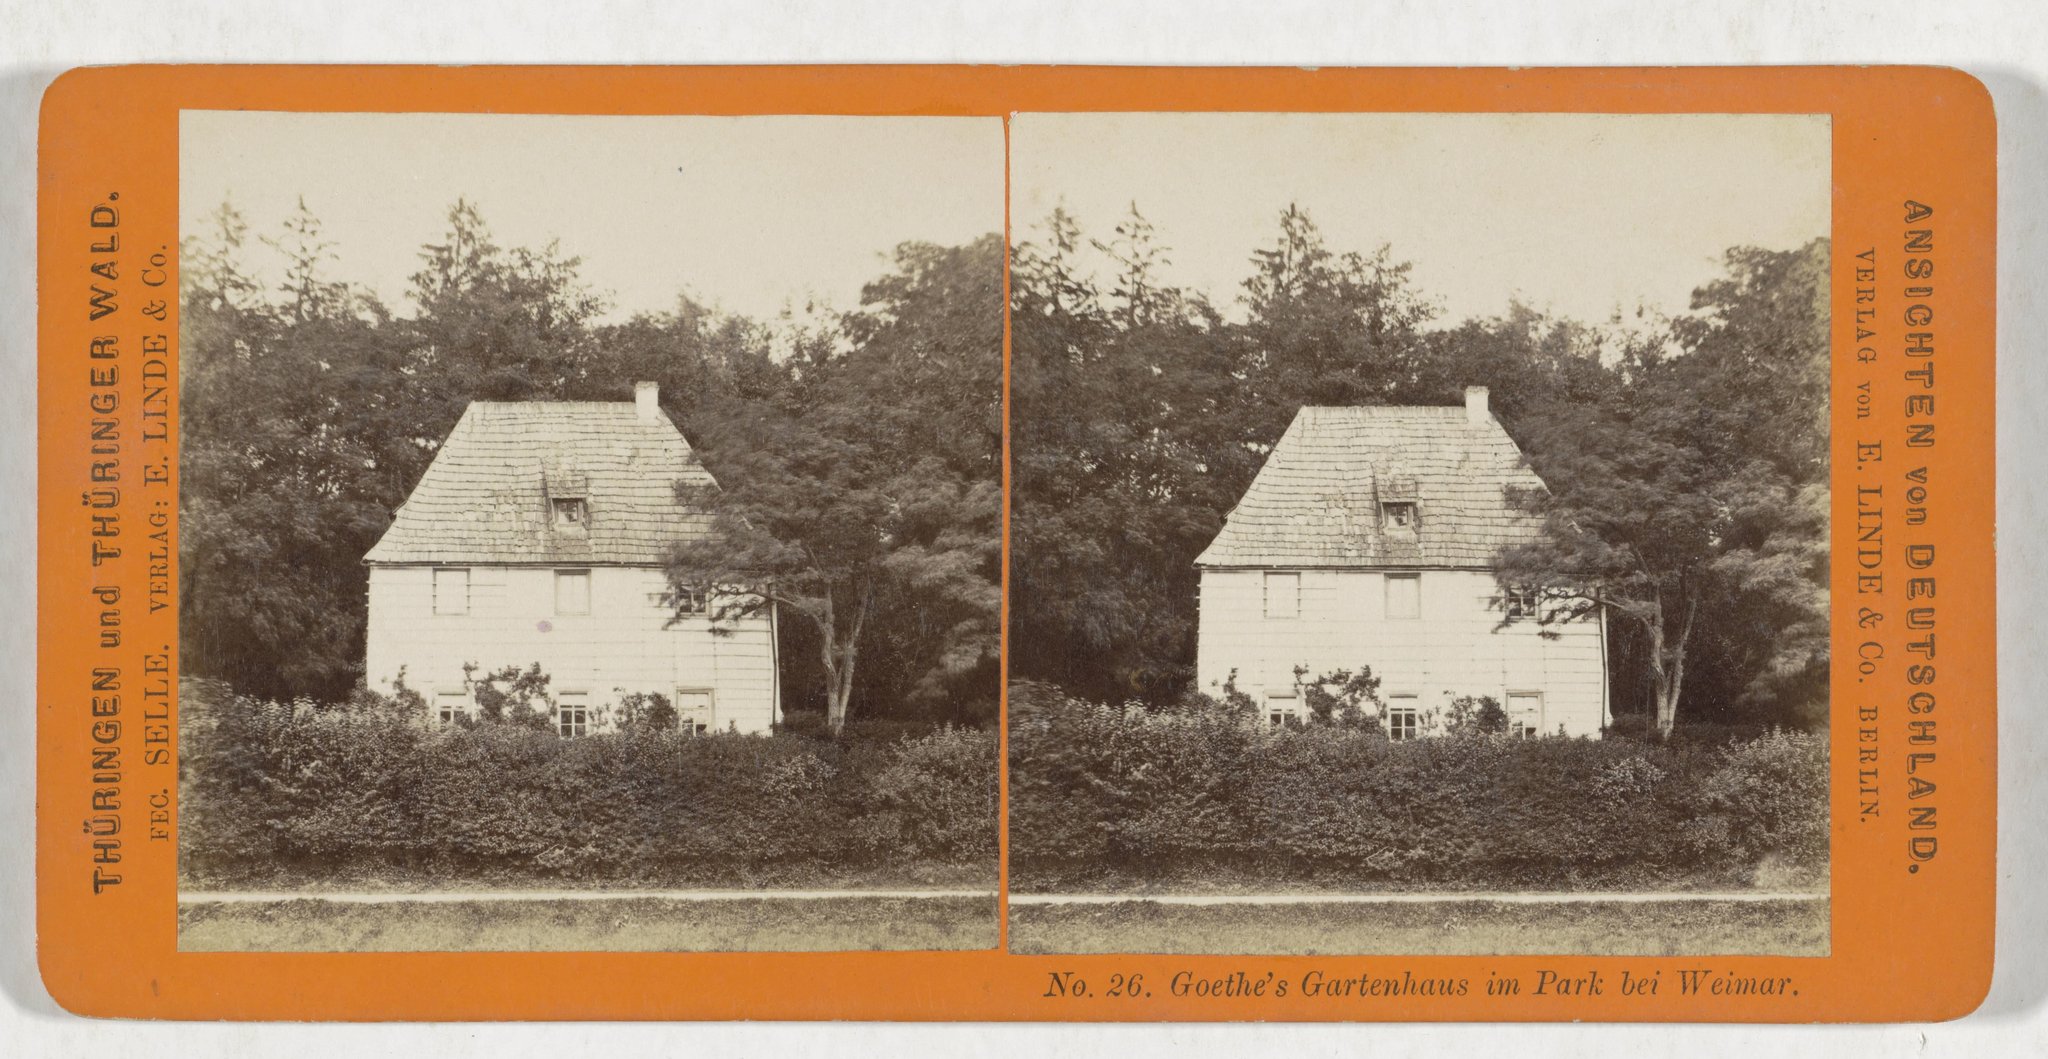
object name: stereograph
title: Tuinhuis van Goethe in Weimar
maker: hermann selle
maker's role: fotograaf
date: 1868-1890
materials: cardboard, paper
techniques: albumen print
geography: berlin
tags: summer-house, arbour, garden-house (dutch: 'theekoepel')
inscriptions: number: ‘No. 26.’